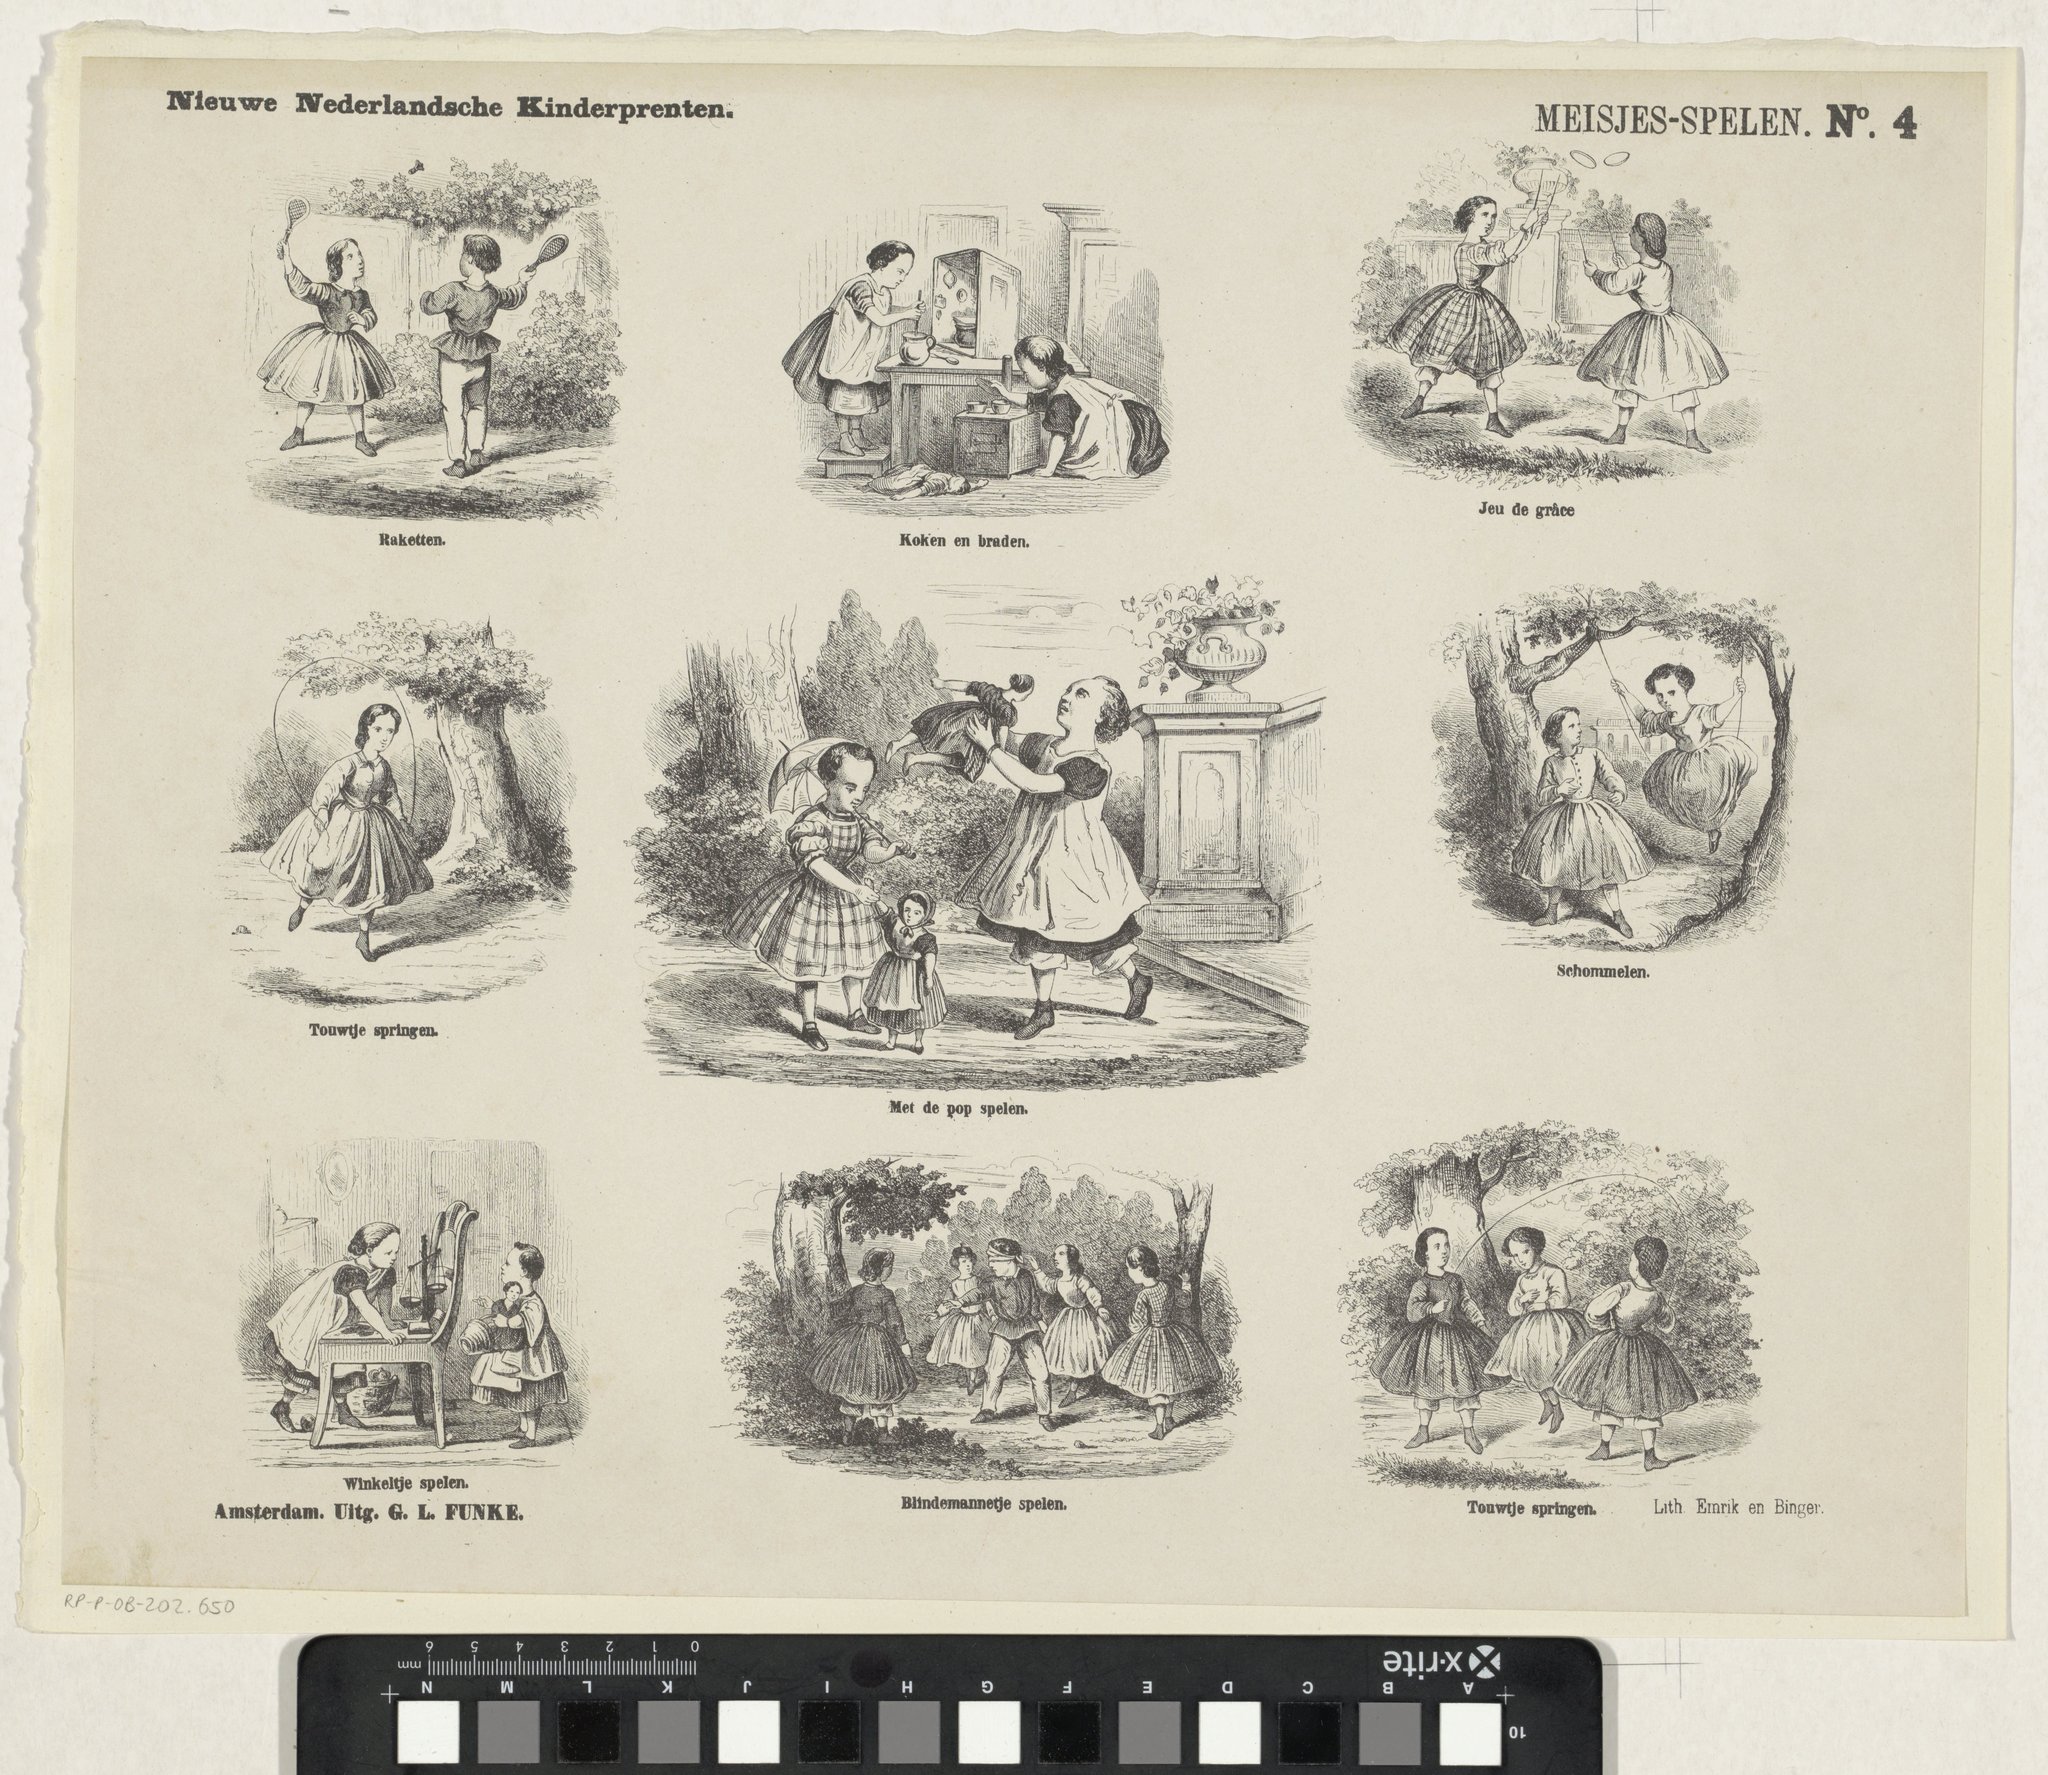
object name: print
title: Nieuwe Nederlandsche kinderprenten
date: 1865-1875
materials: paper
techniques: letterpress printing, lithograph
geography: haarlem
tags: children's games and plays, (playing with) dolls, jumping-rope games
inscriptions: collector's mark: Lugt 2760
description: Blad met 9 voorstellingen van kinderspelen voor meisjes, waaronder touwtjespringen en met de pop spelen. Onder elke afbeelding een onderschrift. Genummerd rechtsboven: No. 4.